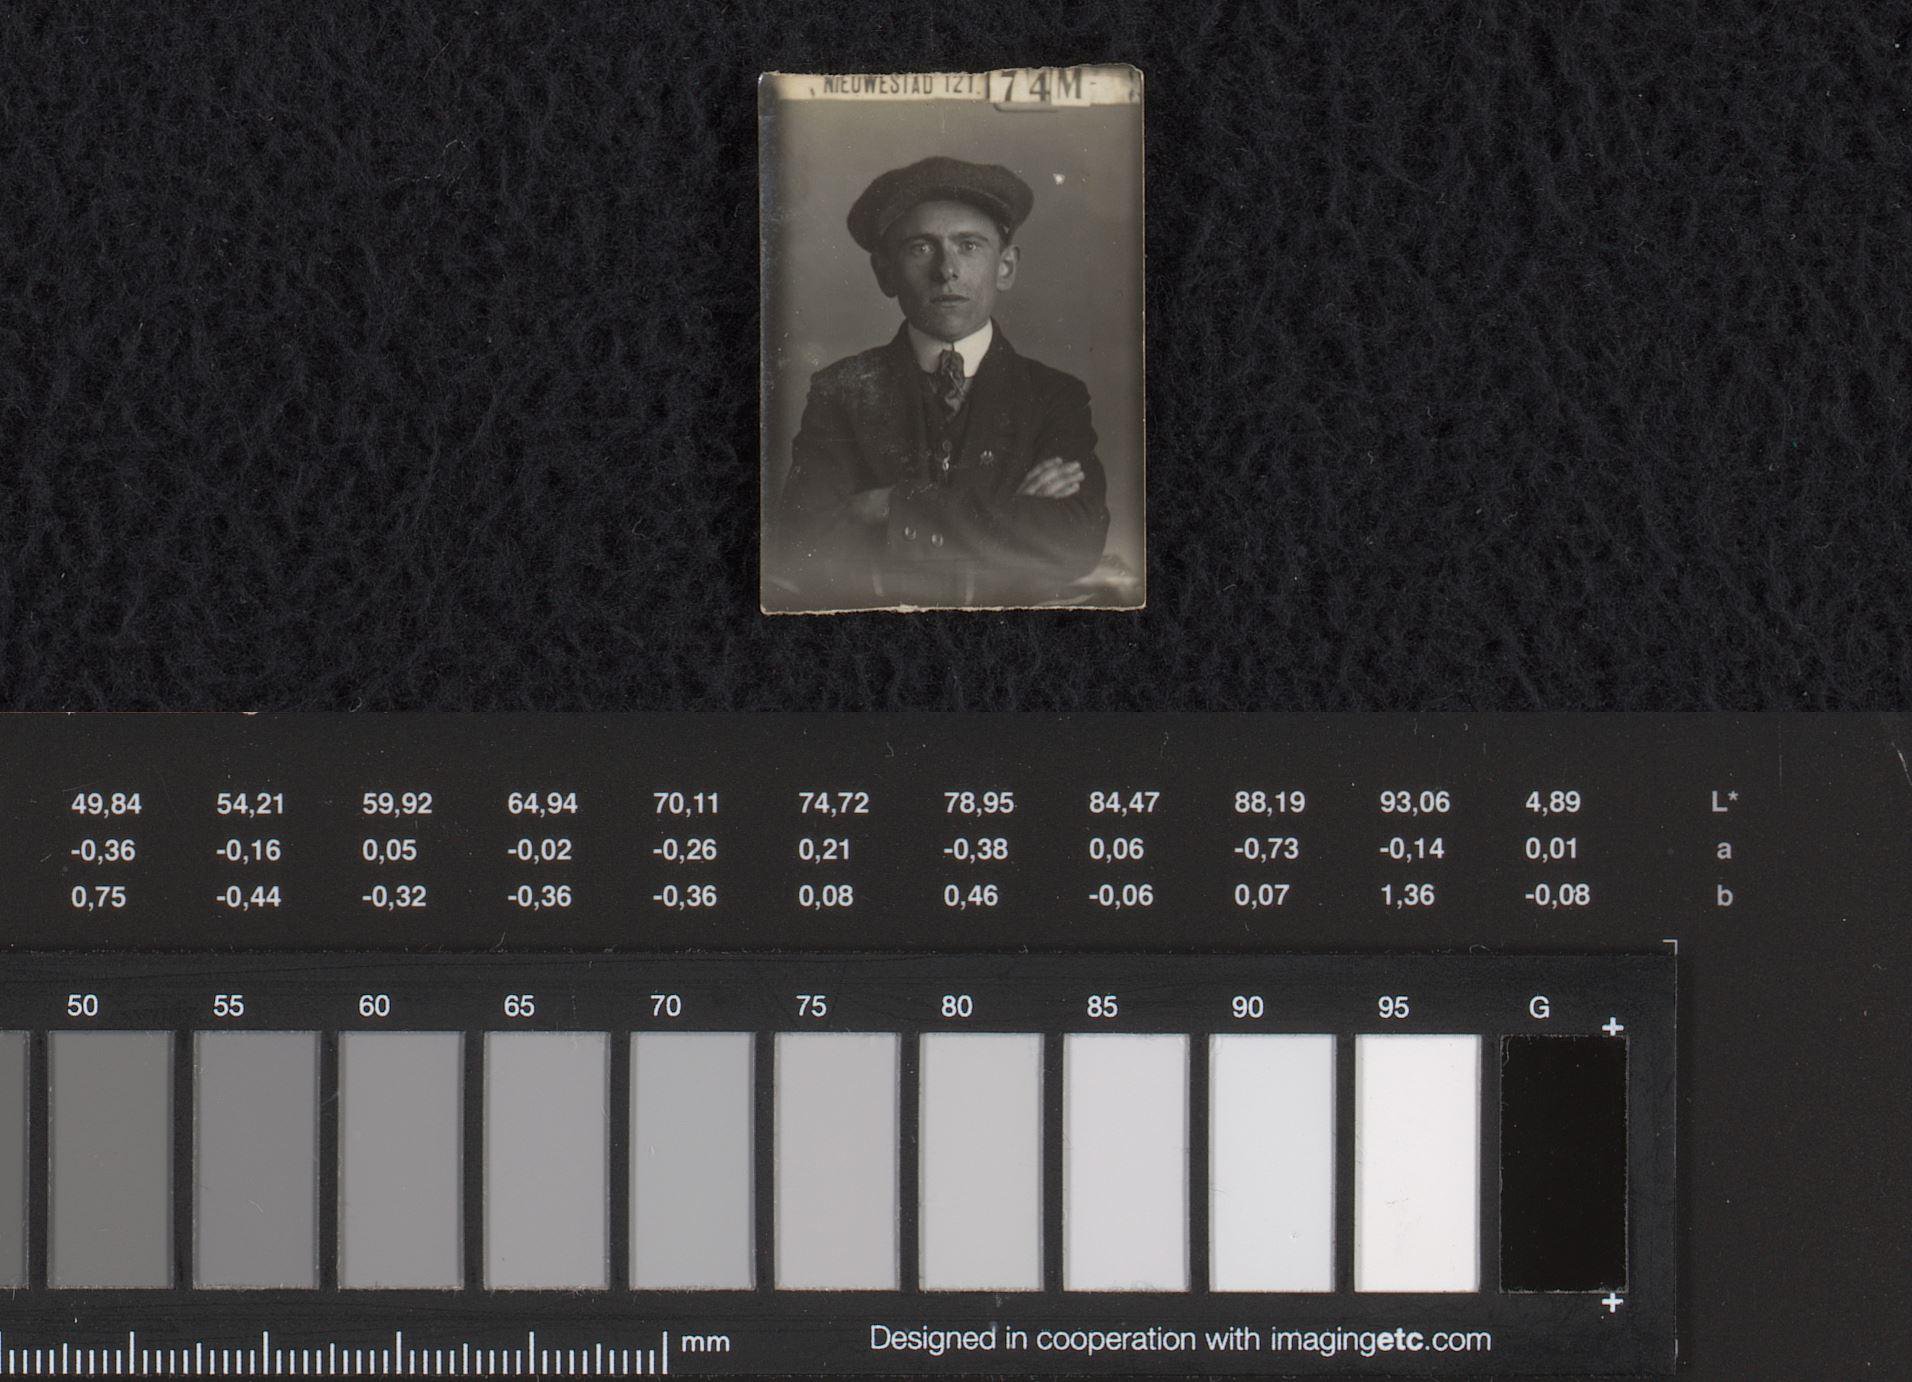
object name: album leaf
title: Portret van een onbekende jongen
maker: Anonymous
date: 1912-1916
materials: paper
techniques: gelatin silver print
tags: anonymous historical person portrayed